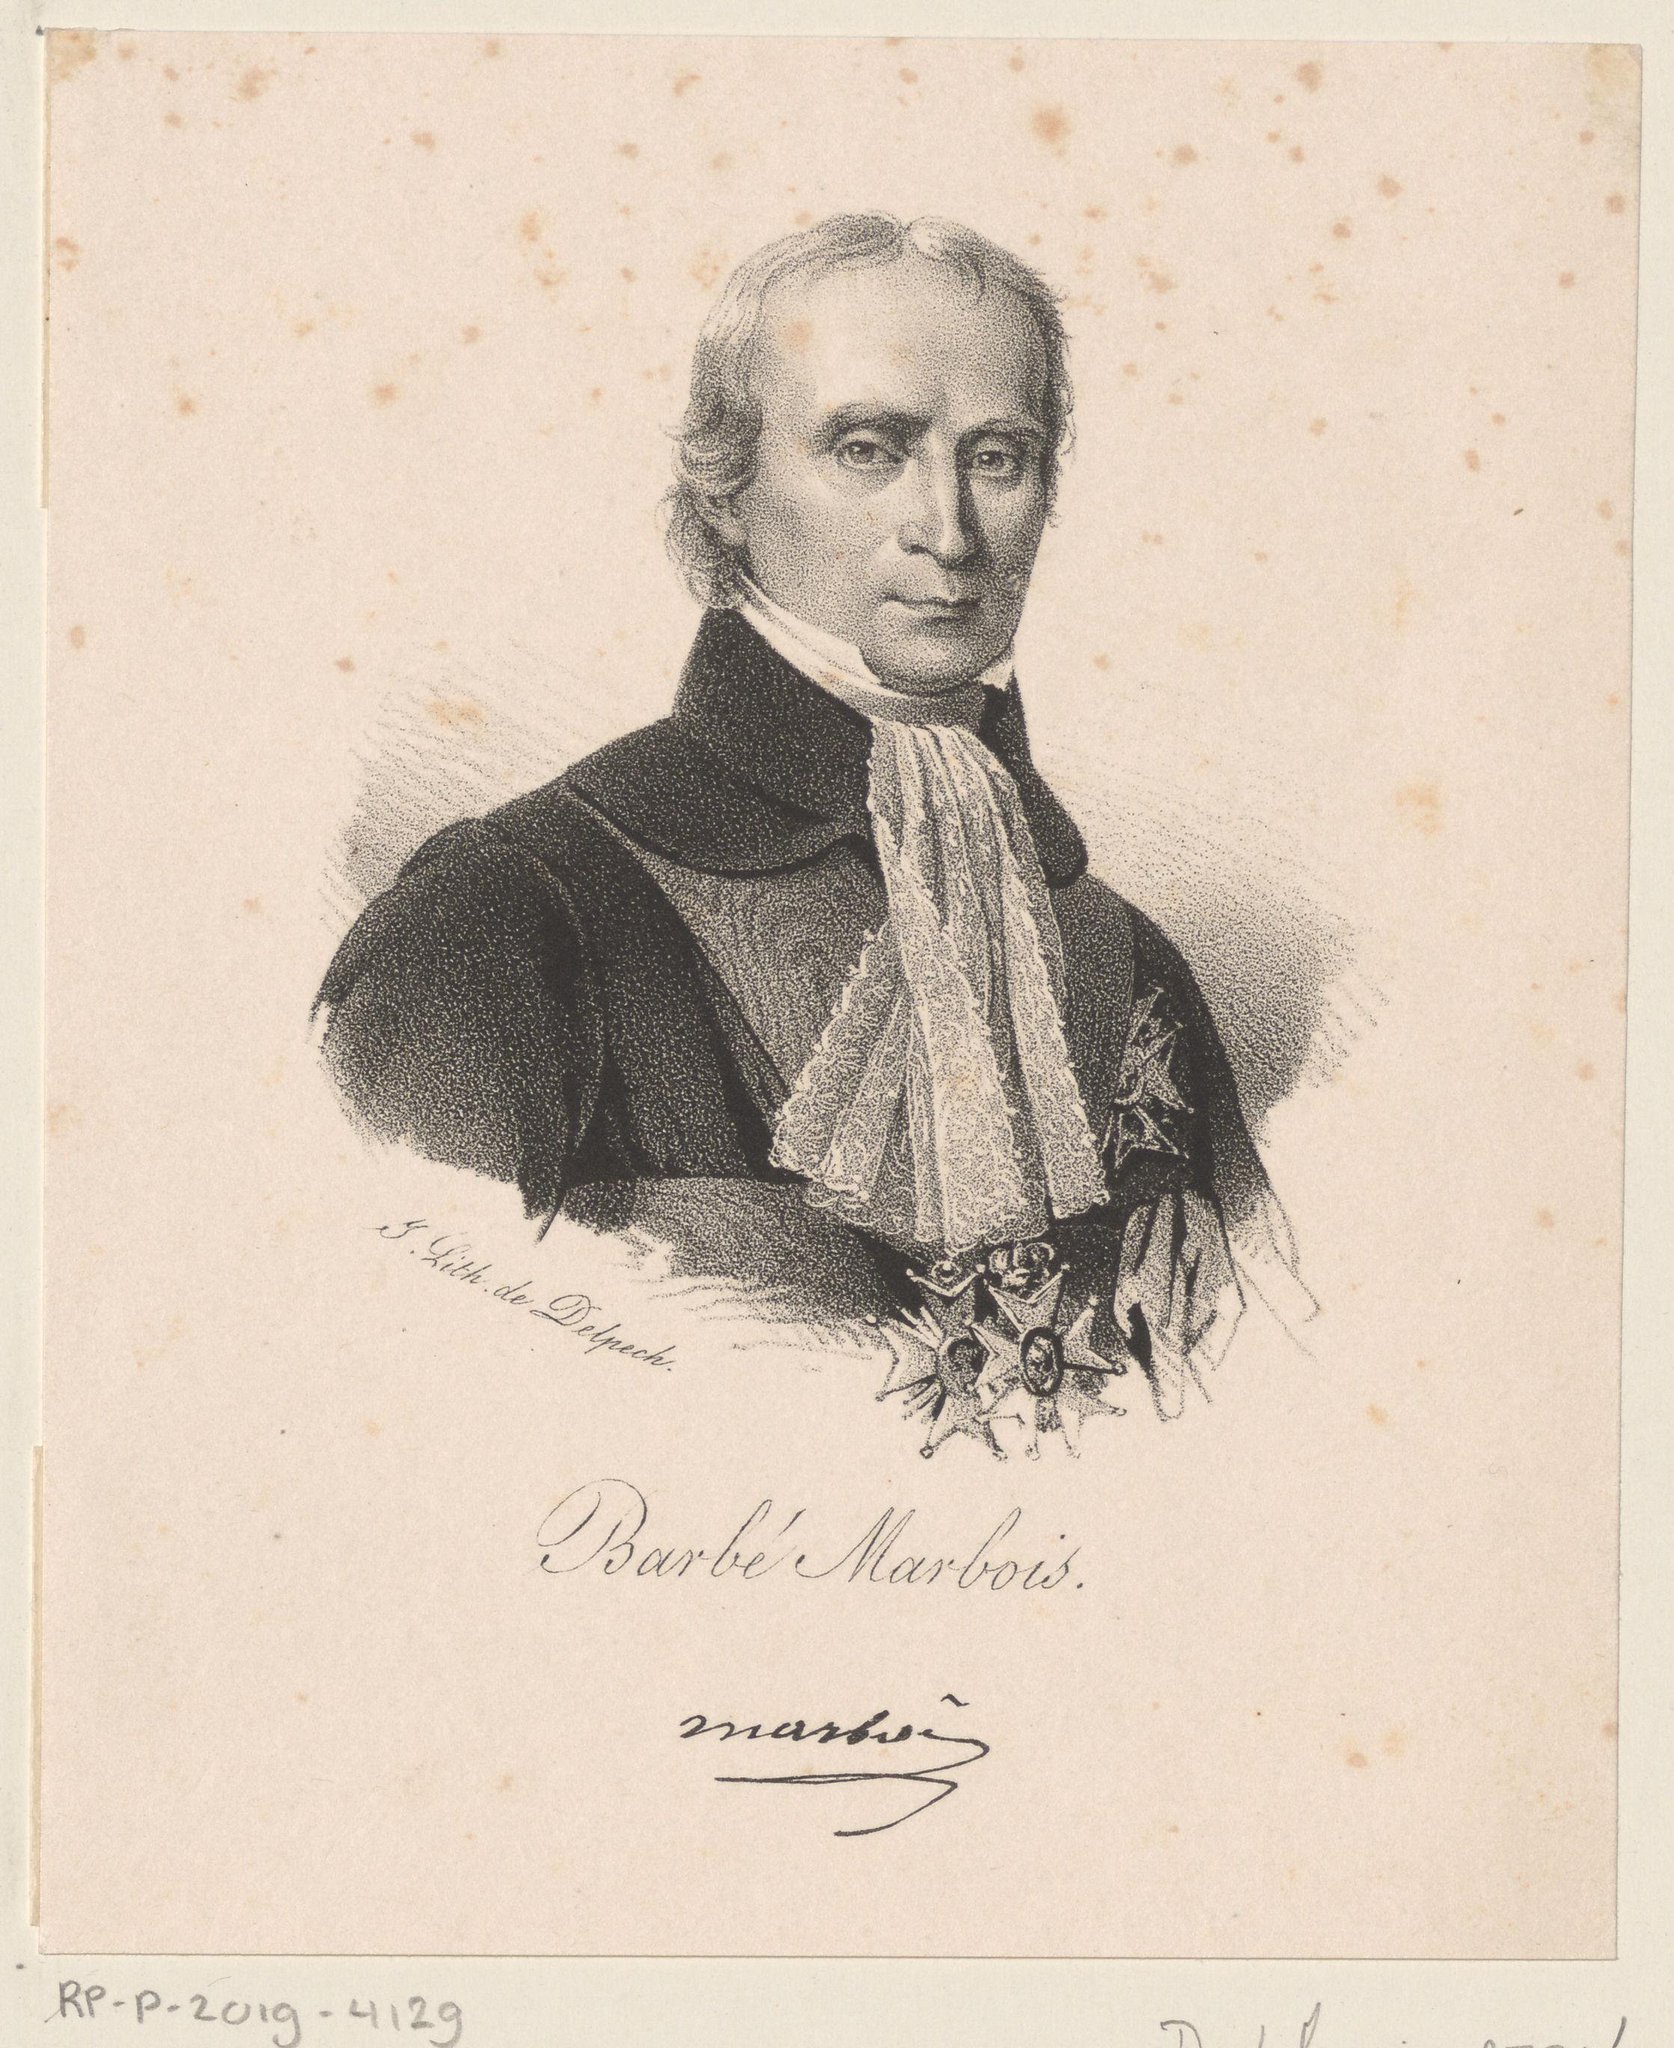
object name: print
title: Portret van François Barbé-Marbois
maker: Anonymous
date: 1818-1842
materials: paper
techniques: lithograph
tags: paris, politician, historical persons